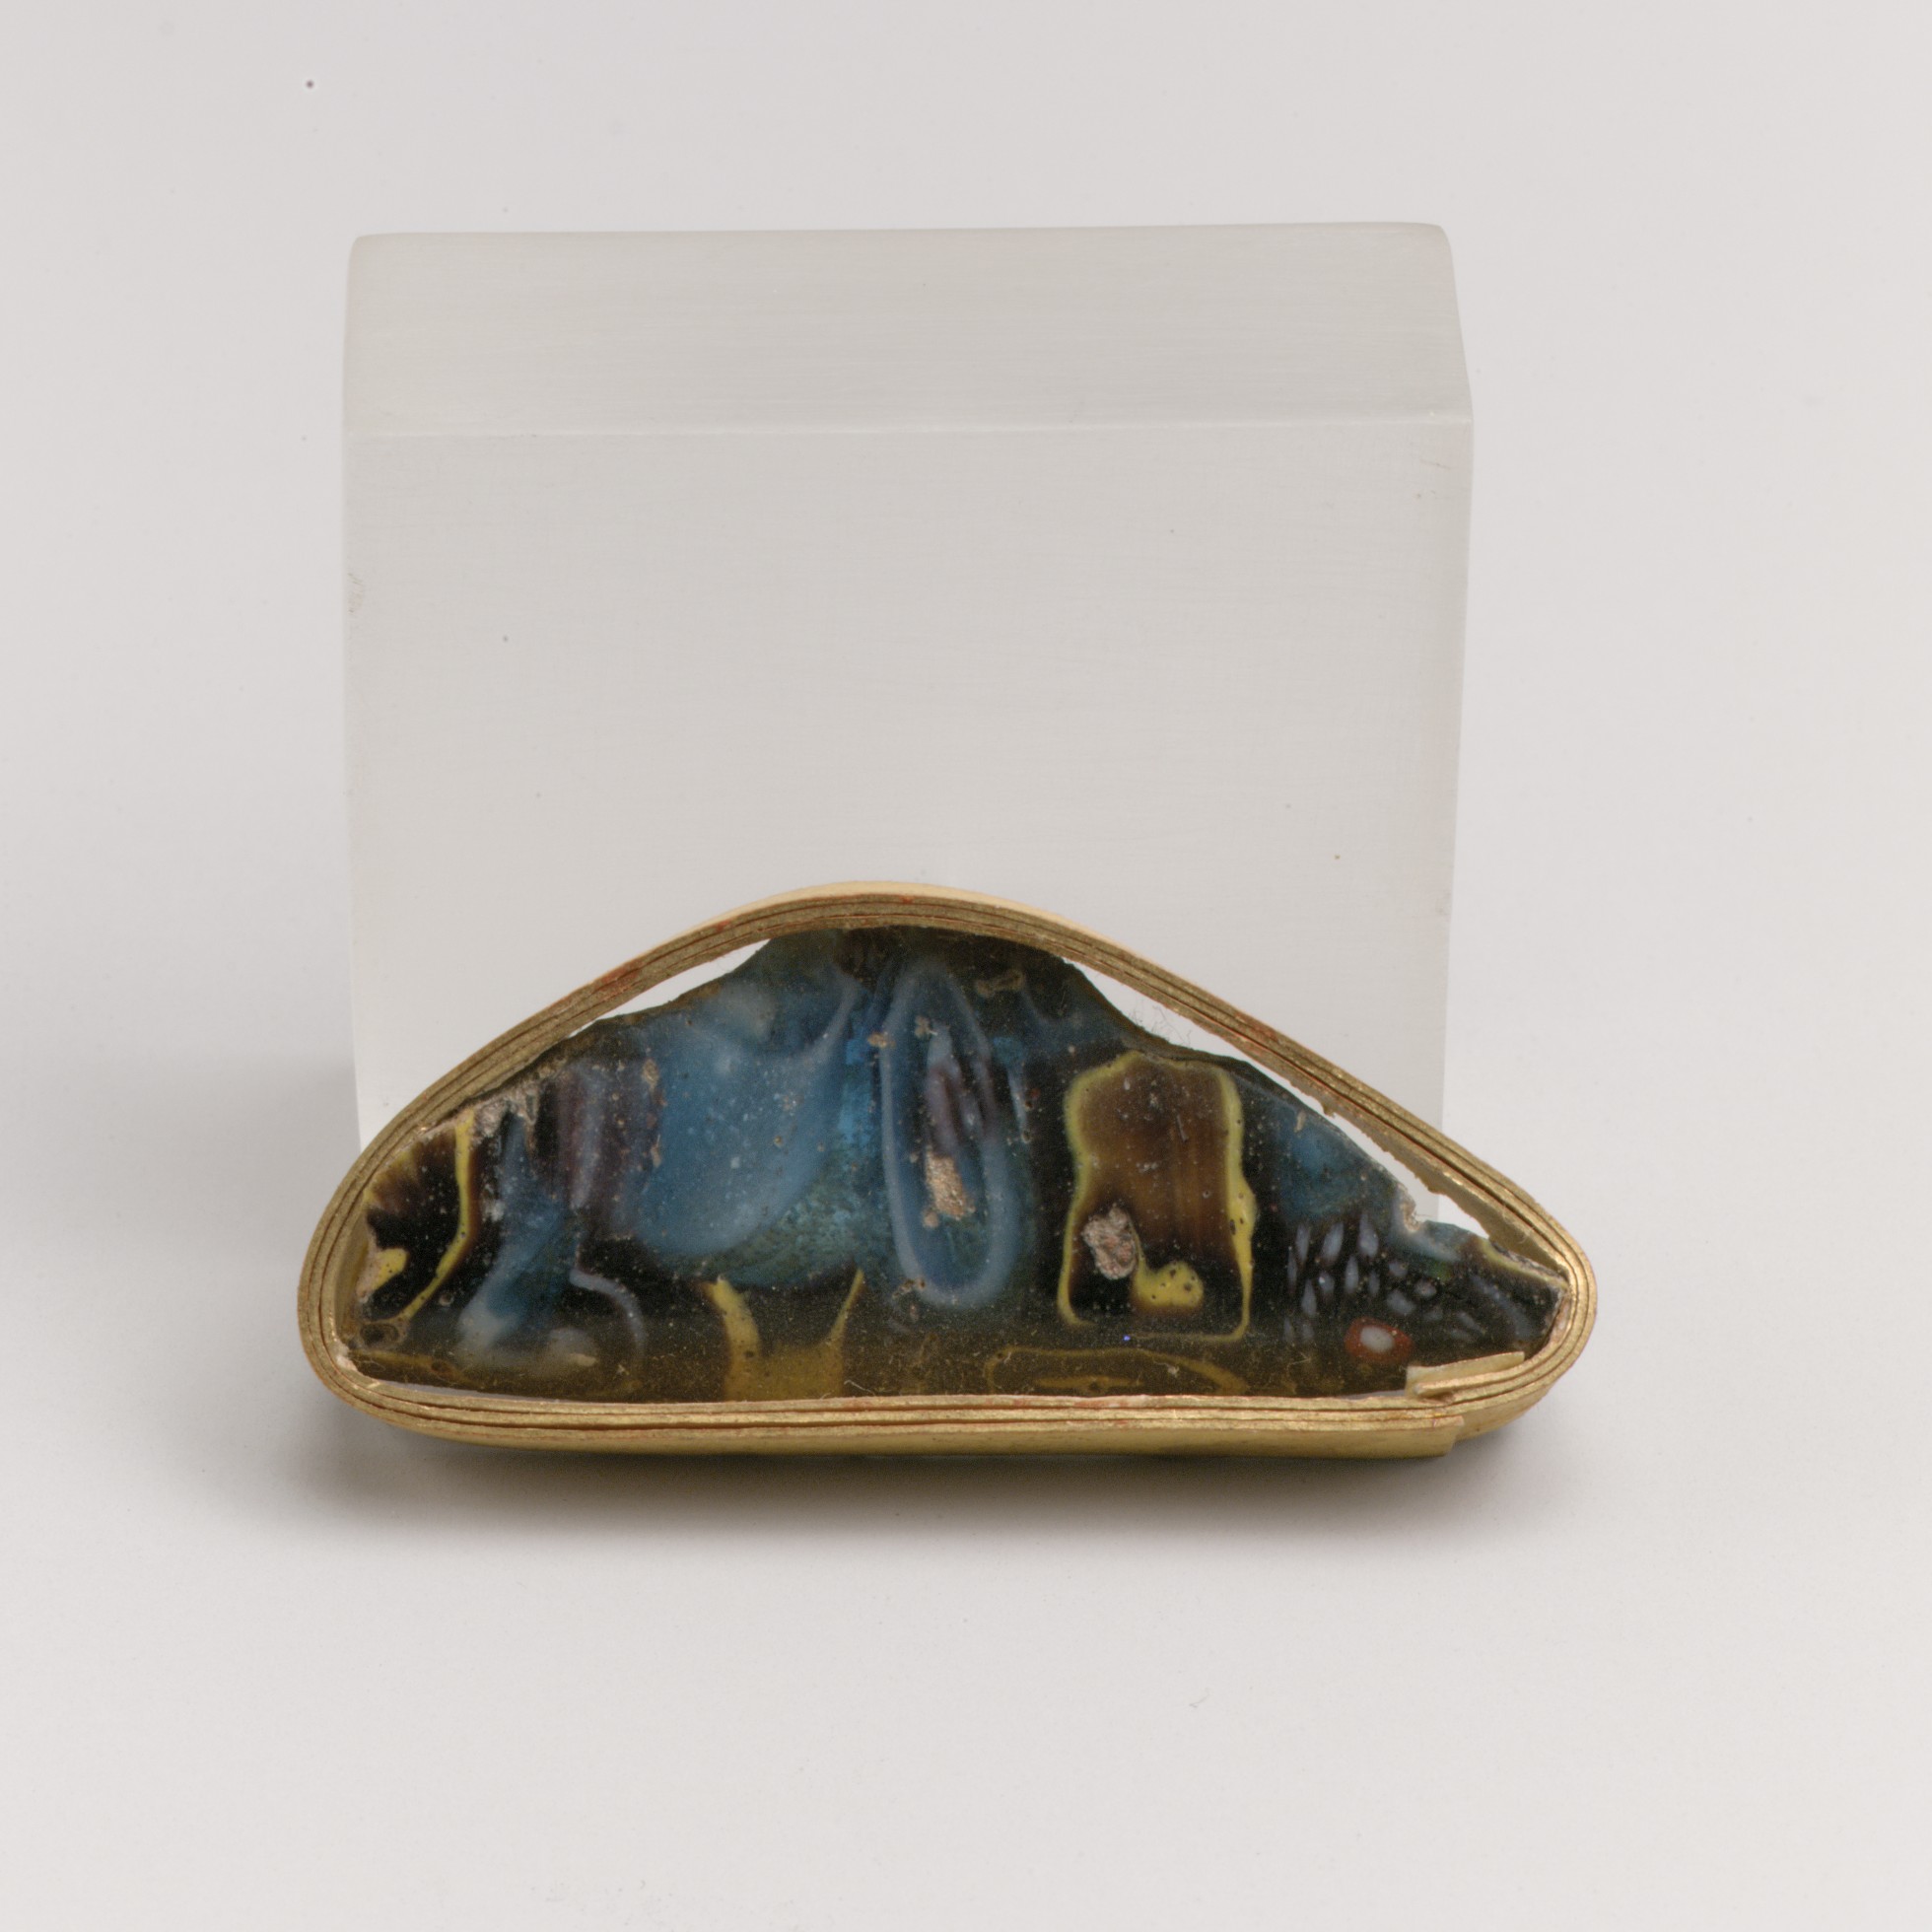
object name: fragment, mosaic bowl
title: Glass mosaic bowl fragment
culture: roman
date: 34 BCE-33 CE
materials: glass